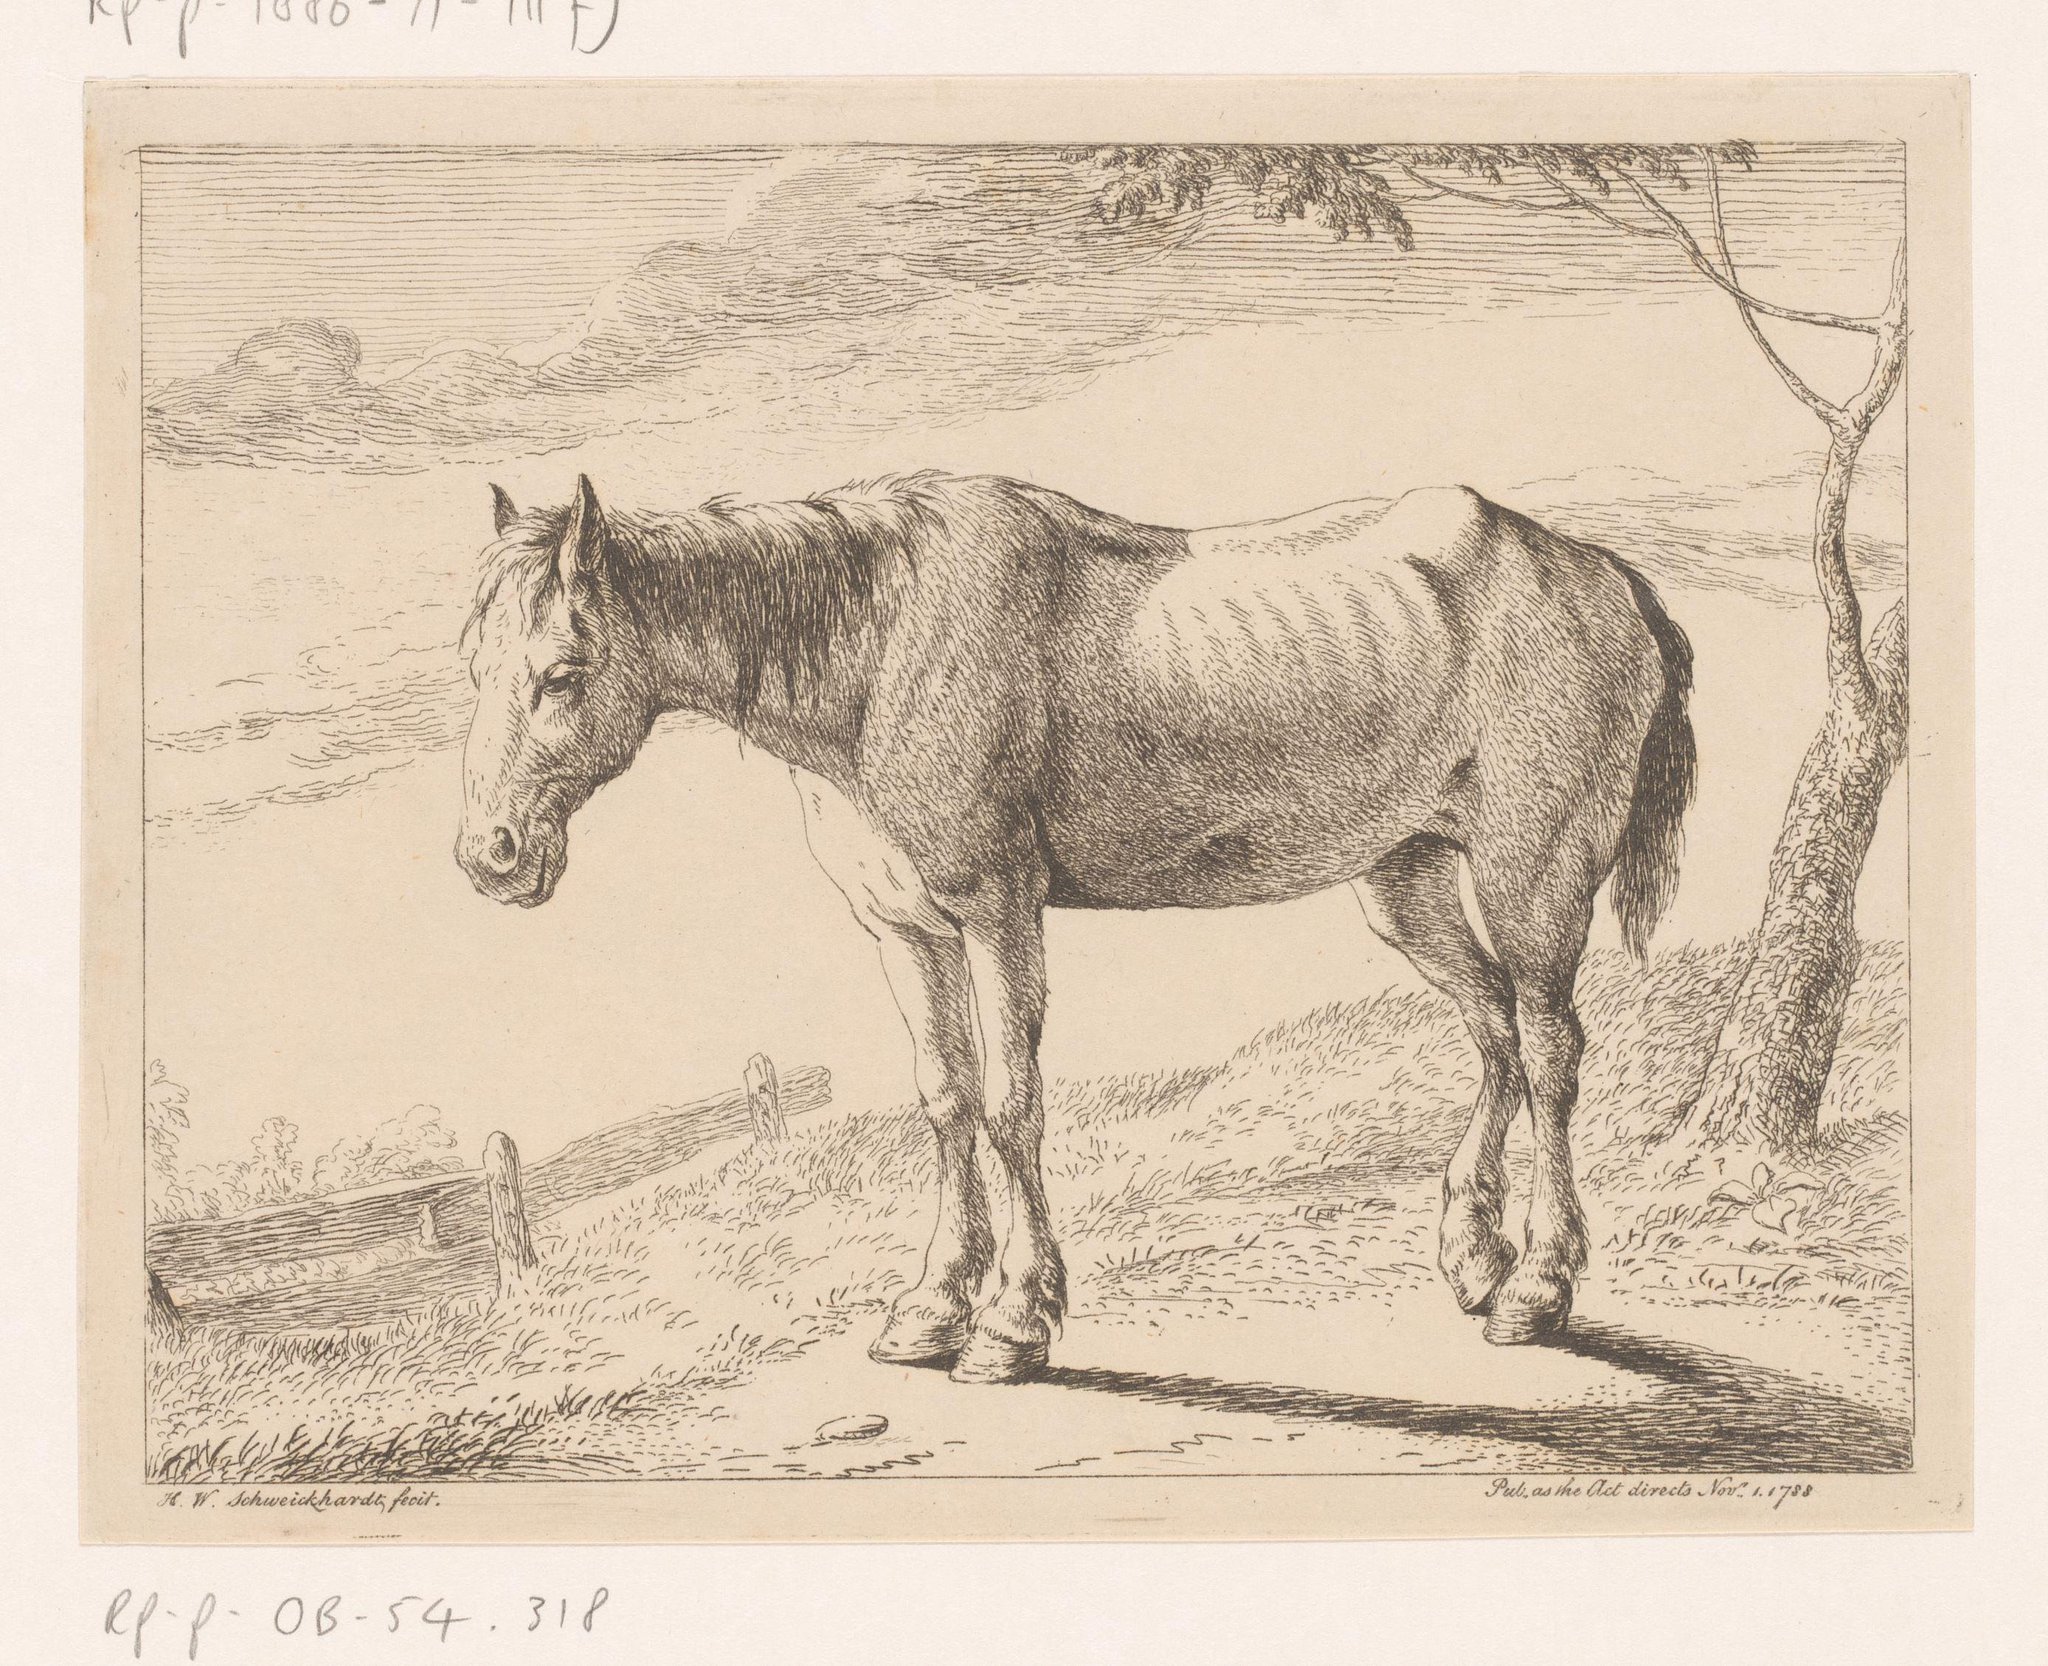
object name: print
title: Verschillende dieren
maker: hendrik willem schweickhardt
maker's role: draughtsman, painter, print maker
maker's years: 1746-1797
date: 1788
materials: paper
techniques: etching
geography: england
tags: horse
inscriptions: collector's mark: Lugt 2228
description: Behoort tot een serie van acht prenten met verschillende dieren.